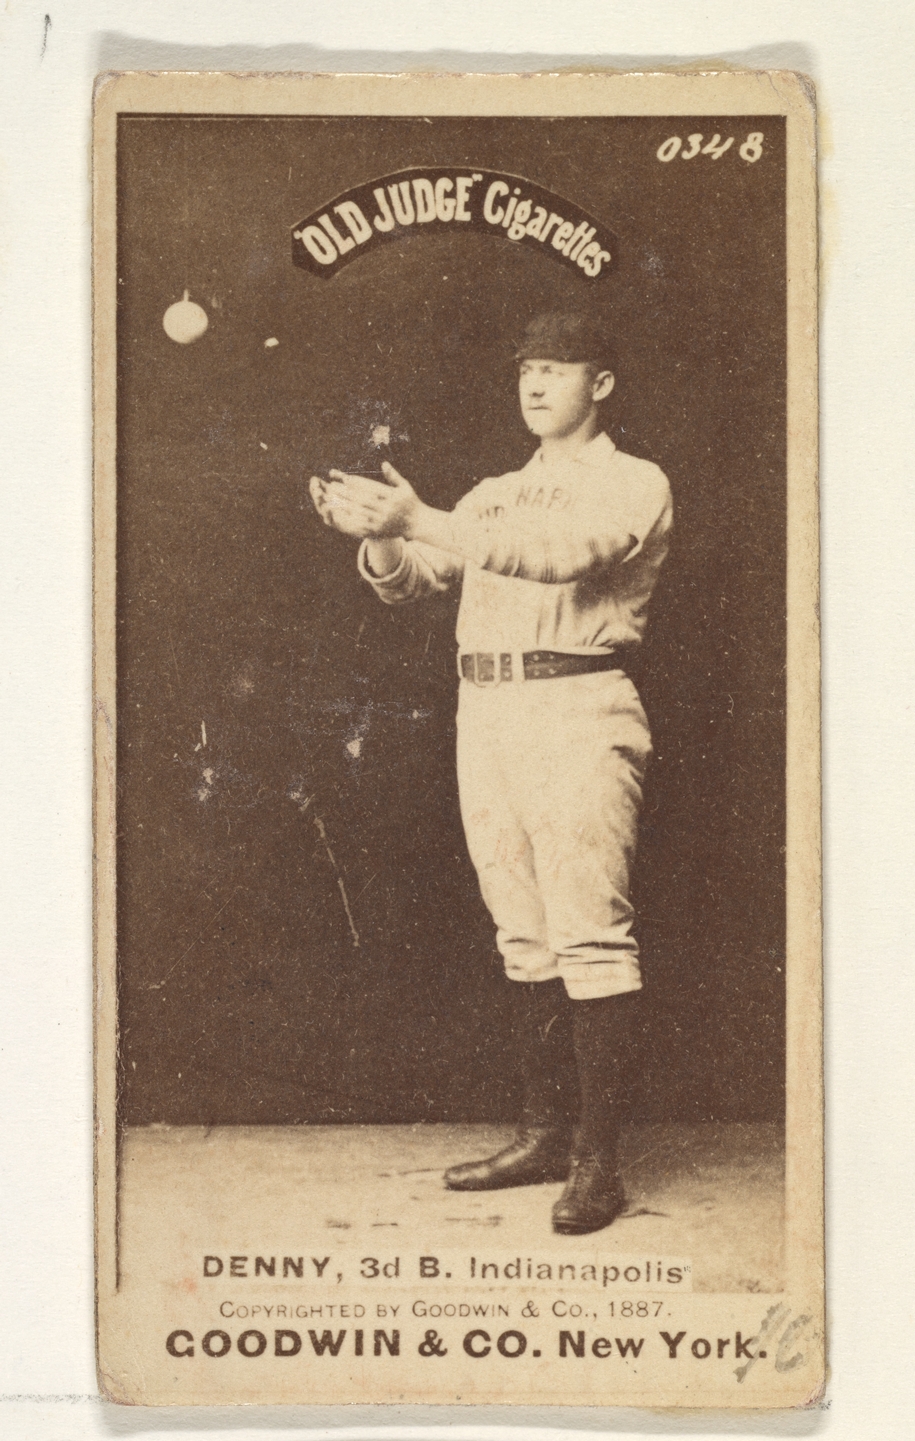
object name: baseball card, photograph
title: Jerry Denny, 3rd Base, Indianapolis, from the Old Judge series (N172) for Old Judge Cigarettes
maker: goodwin & company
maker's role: publisher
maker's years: 1850-1950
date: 1887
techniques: albumen silver print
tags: men,portraits,baseball,athletes